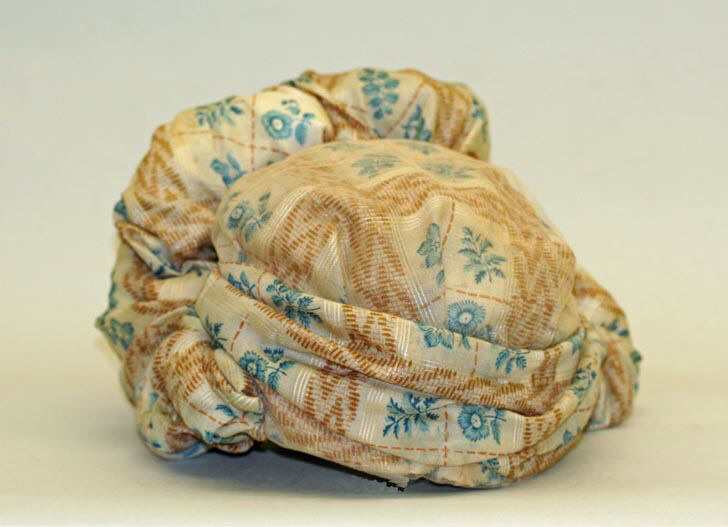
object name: evening turban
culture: american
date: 1823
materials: cotton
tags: flowers